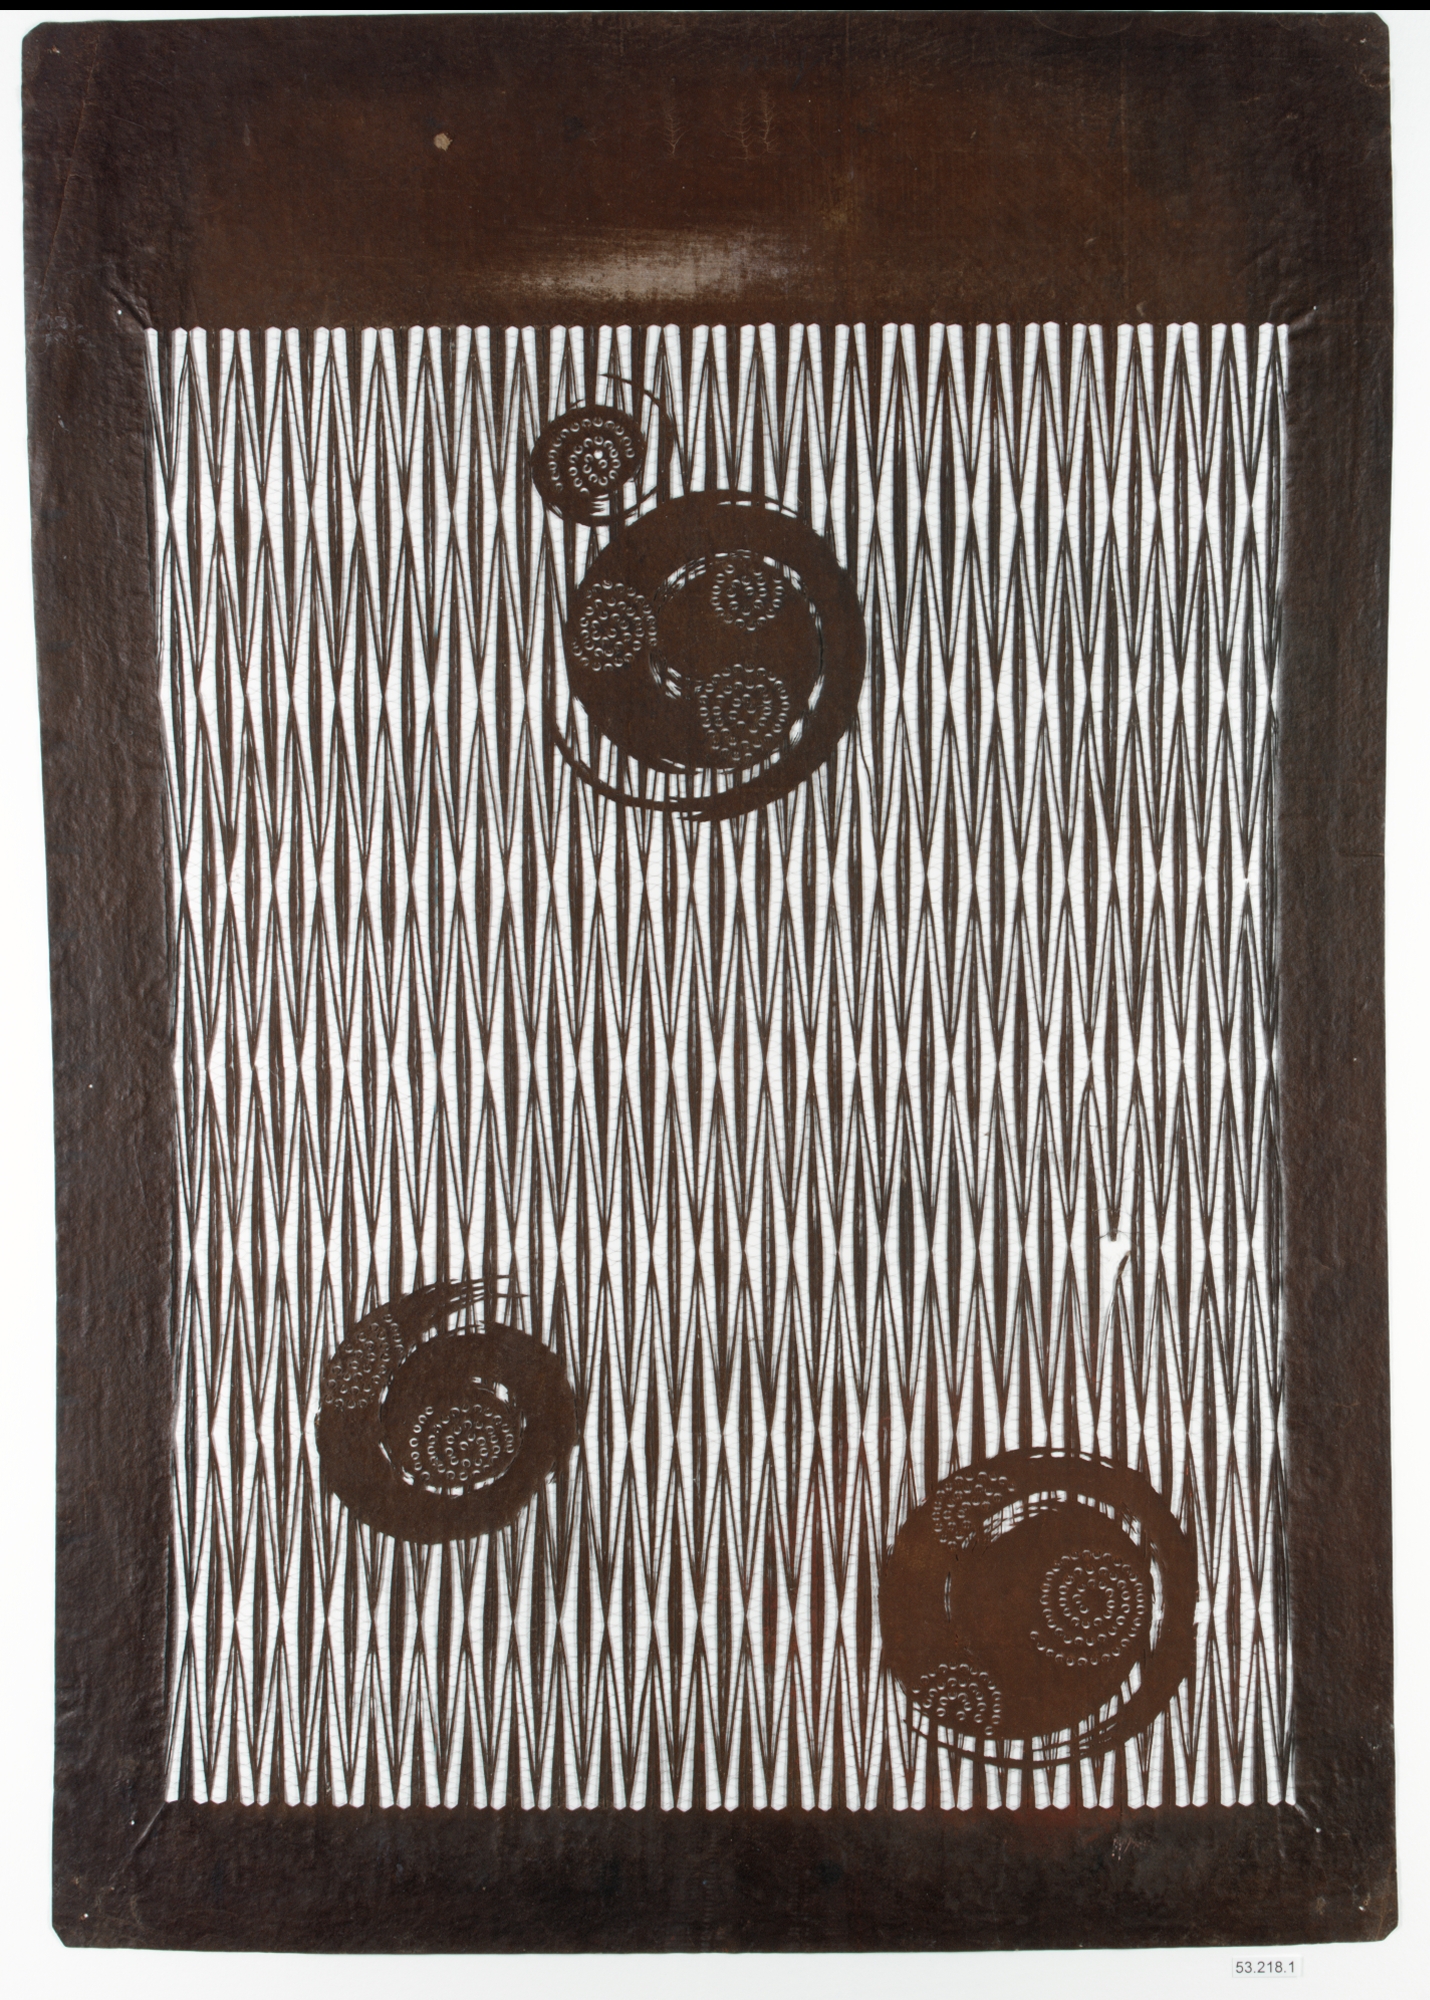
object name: stencil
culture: japanese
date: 1801-1900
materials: paper